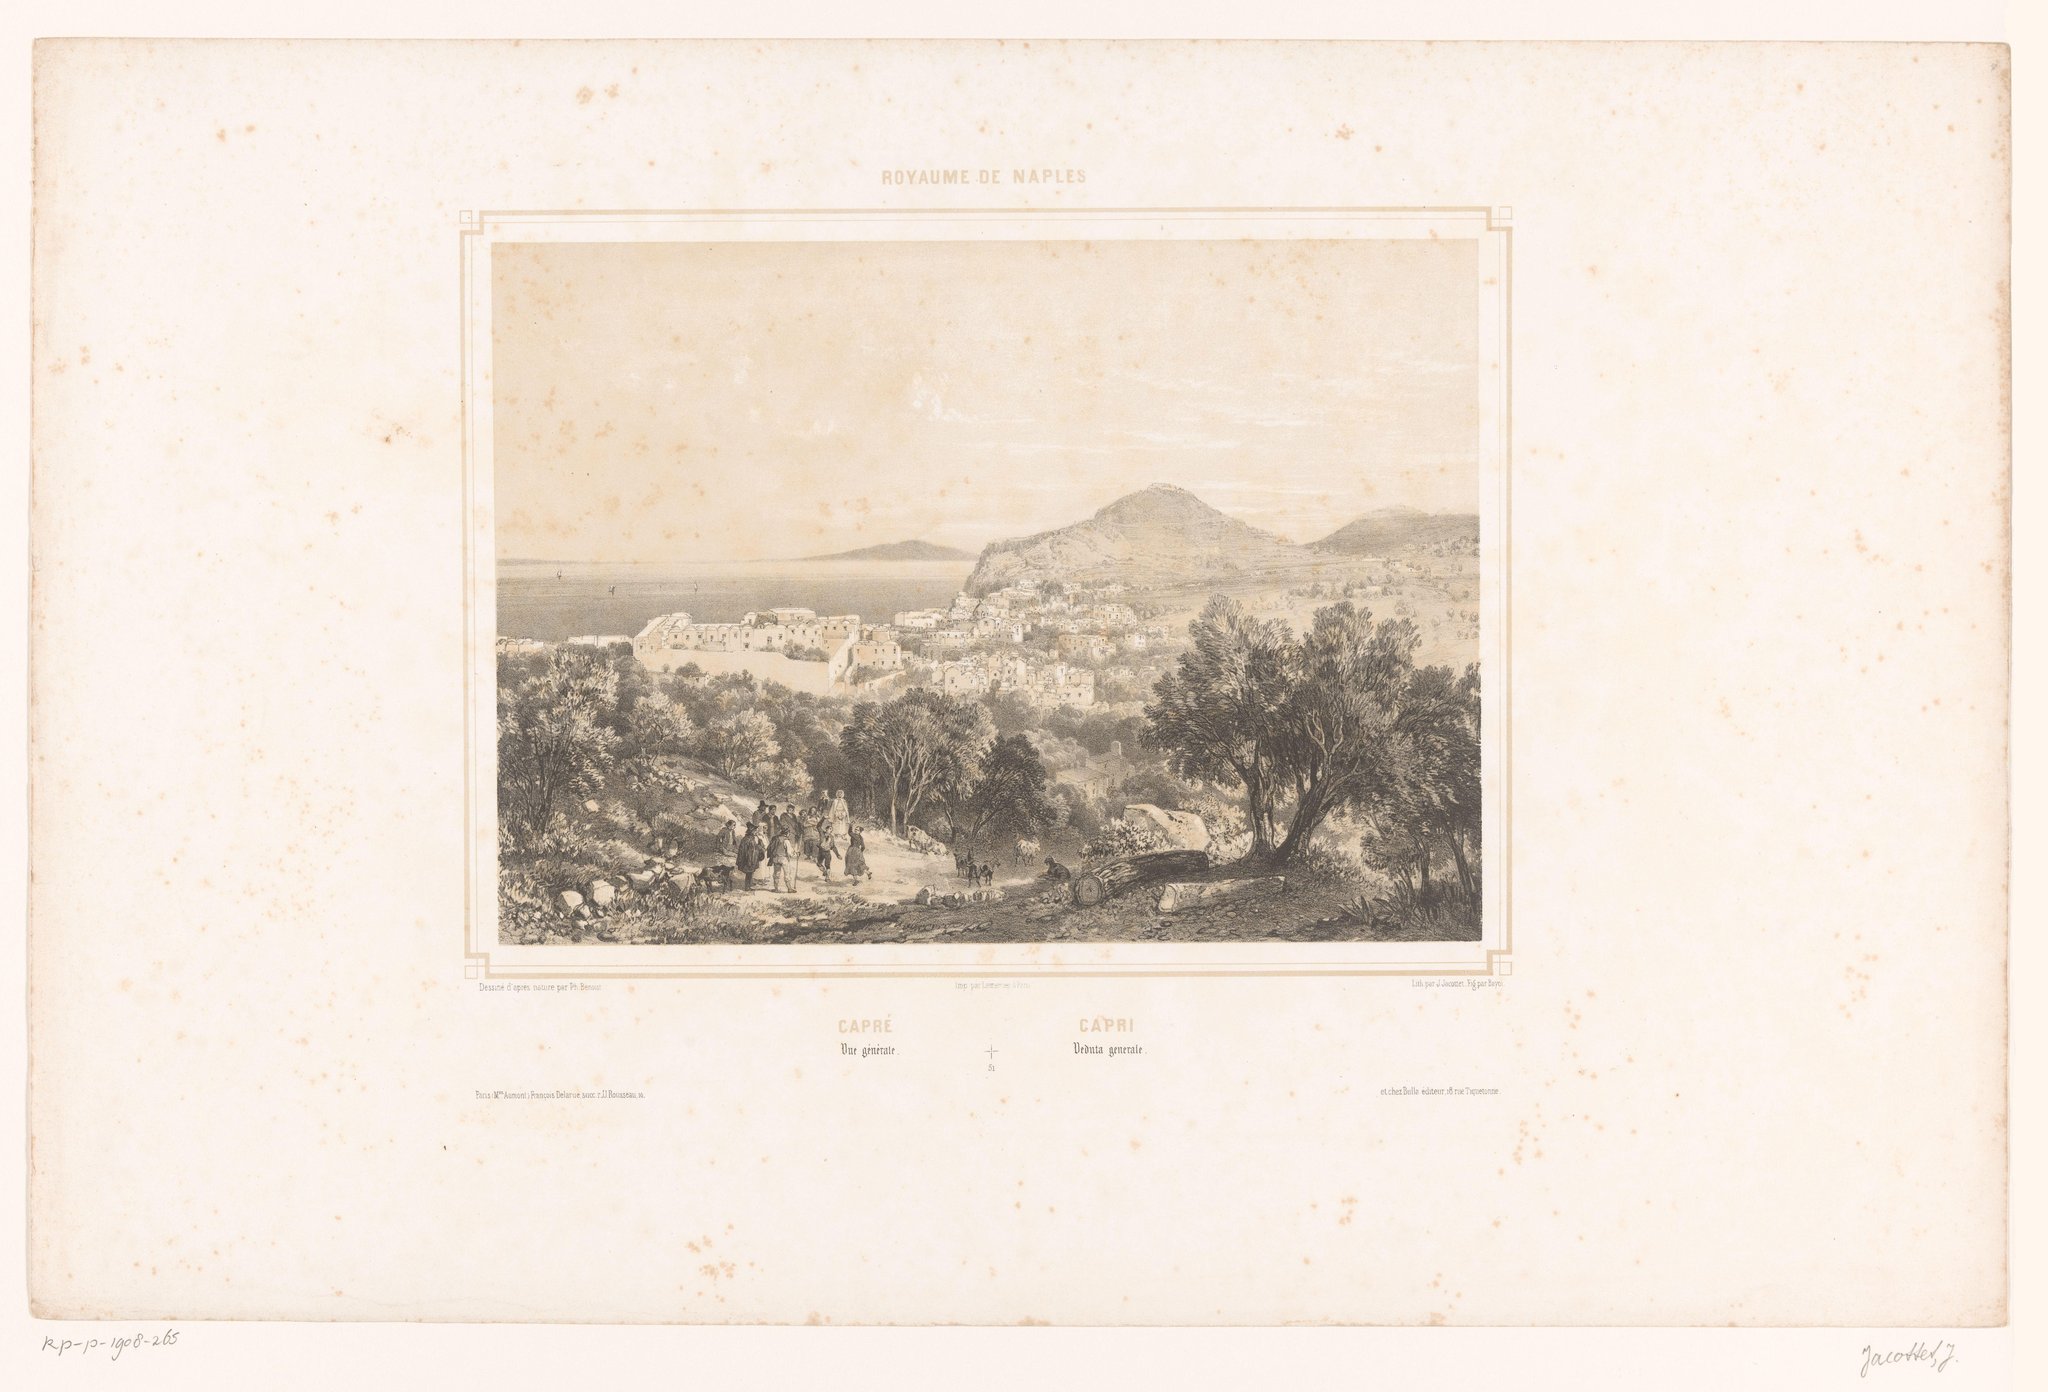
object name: print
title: Royaume de Naples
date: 1846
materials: paper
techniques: tone lithography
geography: paris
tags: prospect of village, silhouette of village, gulf, bay (+ landscape with figures, staffage), island (+ landscape with figures, staffage), capri, isola di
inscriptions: collector's mark: Lugt 2228a